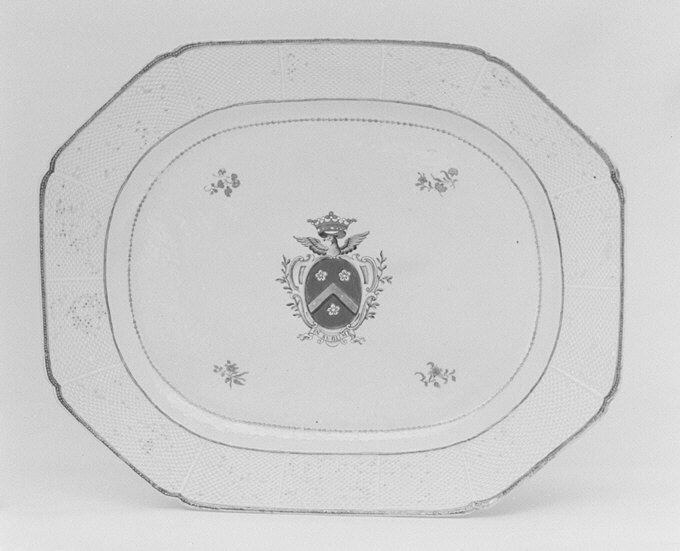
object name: platter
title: Platter (part of a service)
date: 1770-1785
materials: hard paste porcelain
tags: birds,coat of arms